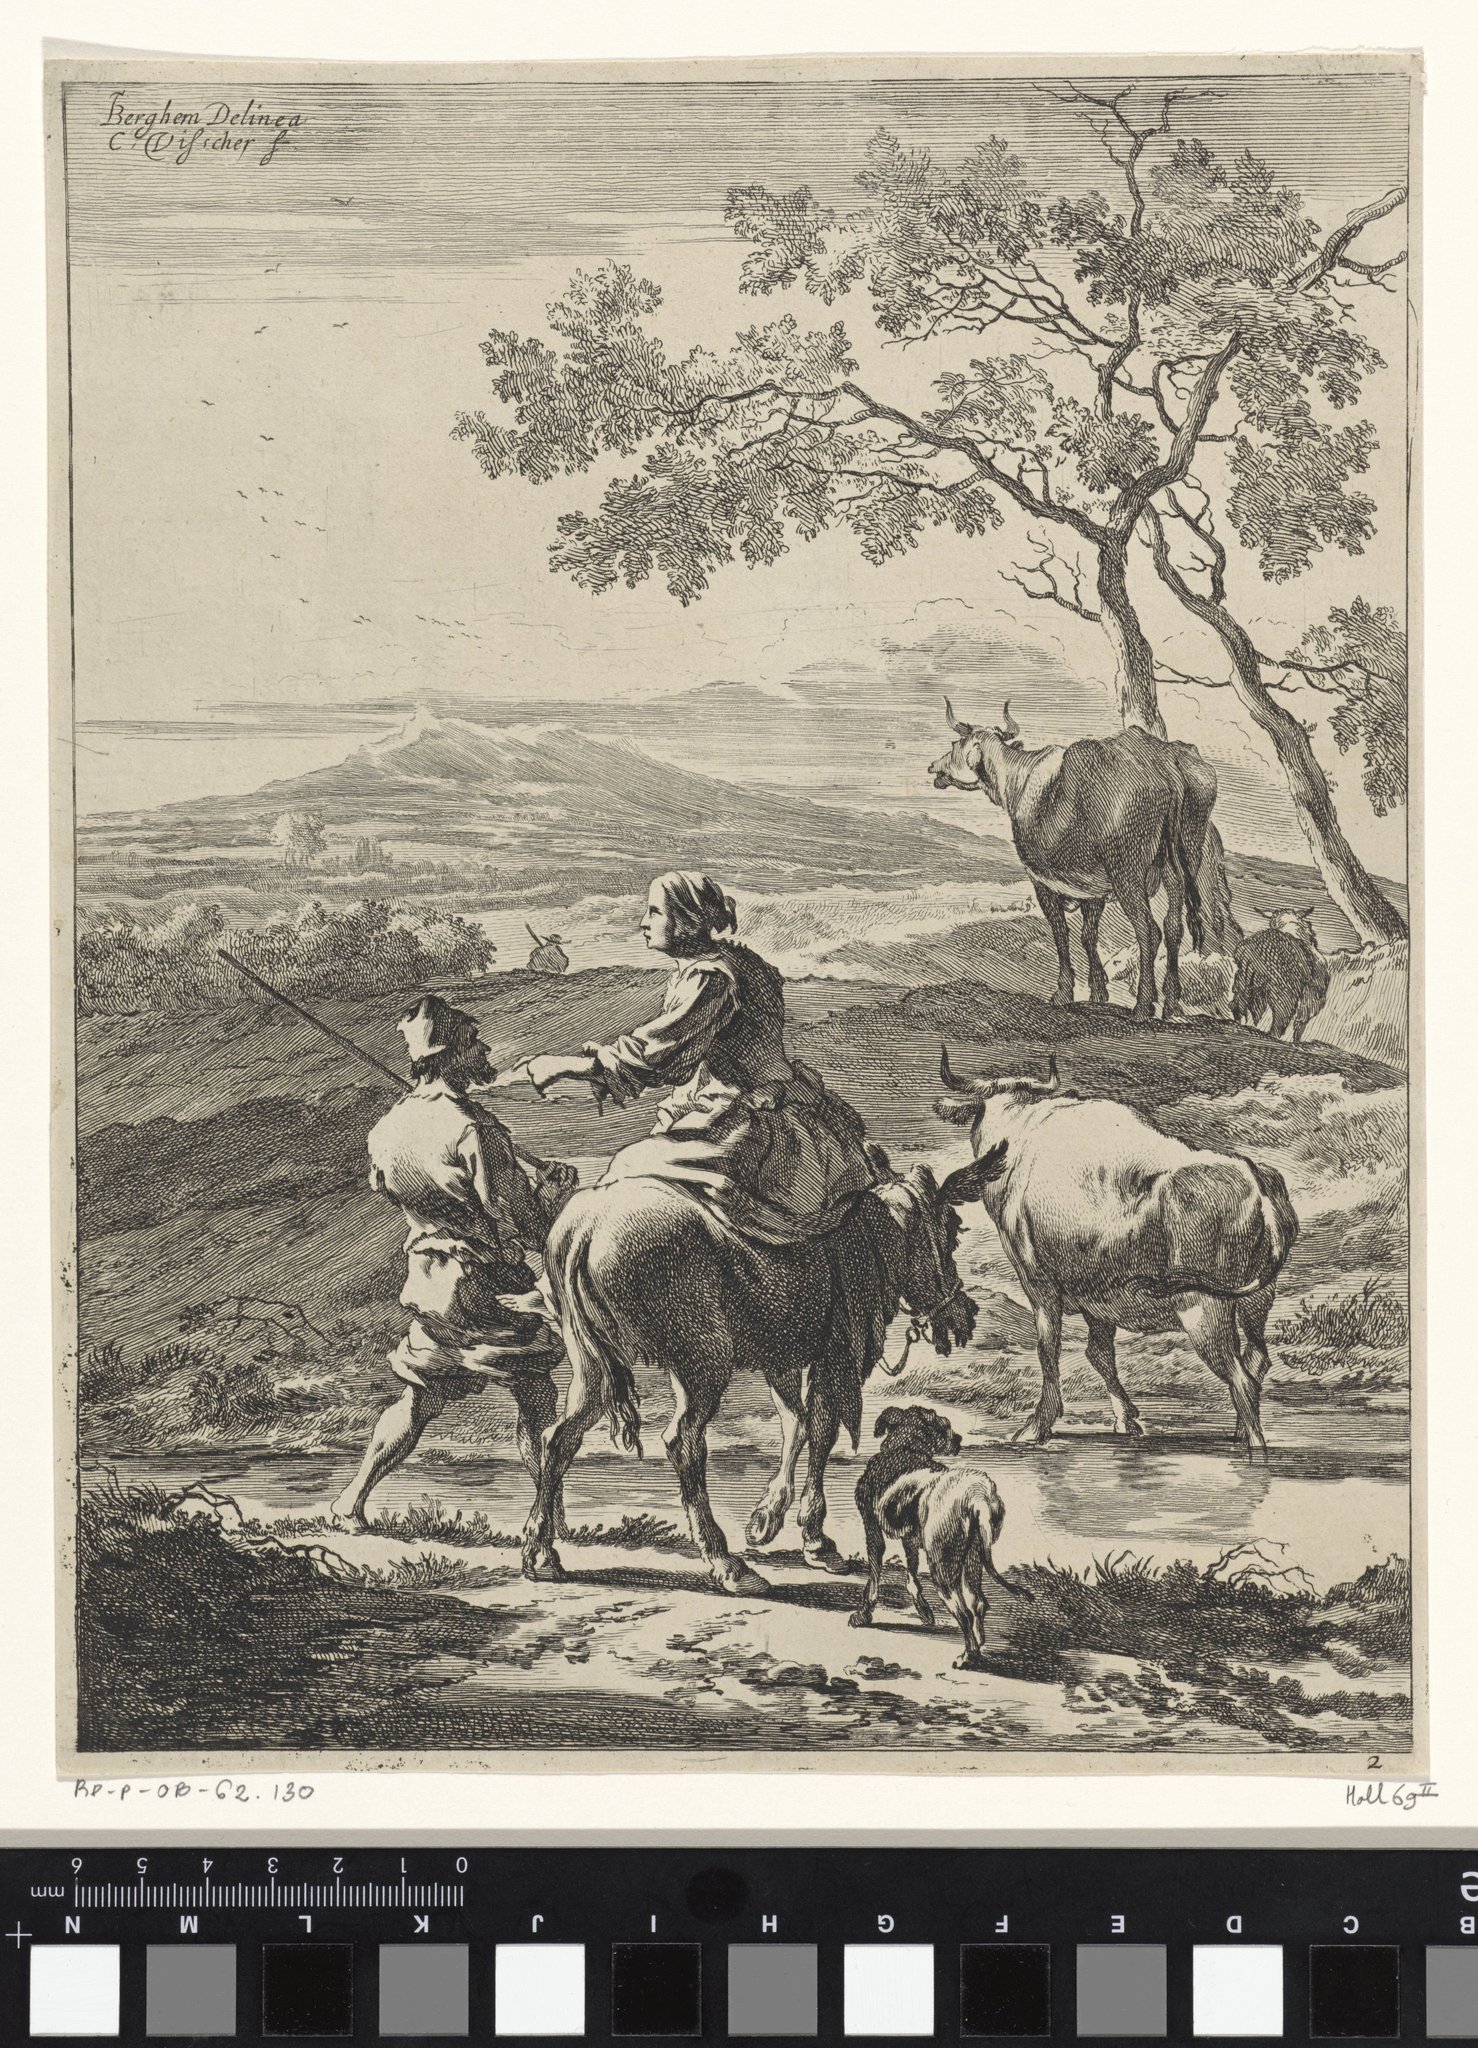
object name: print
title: Herderin op een ezel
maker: nicolaes pietersz berchem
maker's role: draughtsman, print maker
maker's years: 1620-1683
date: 1657-1658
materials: paper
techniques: engraving, etching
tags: low hill country, cow, ass, donkey, herding, herdsman, herdswoman, shepherd, shepherdess, cowherd, etc., dog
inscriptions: collector's mark: Lugt 240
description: Glooiend weids landschap met op de voorgrond een riviertje. Een herderin rijdt op een ezel; links van haar een man emt stok over de schouer, rechts een hond. Een koe waads door het water. Op het tweede plan een koe en een schapp onder een boom.